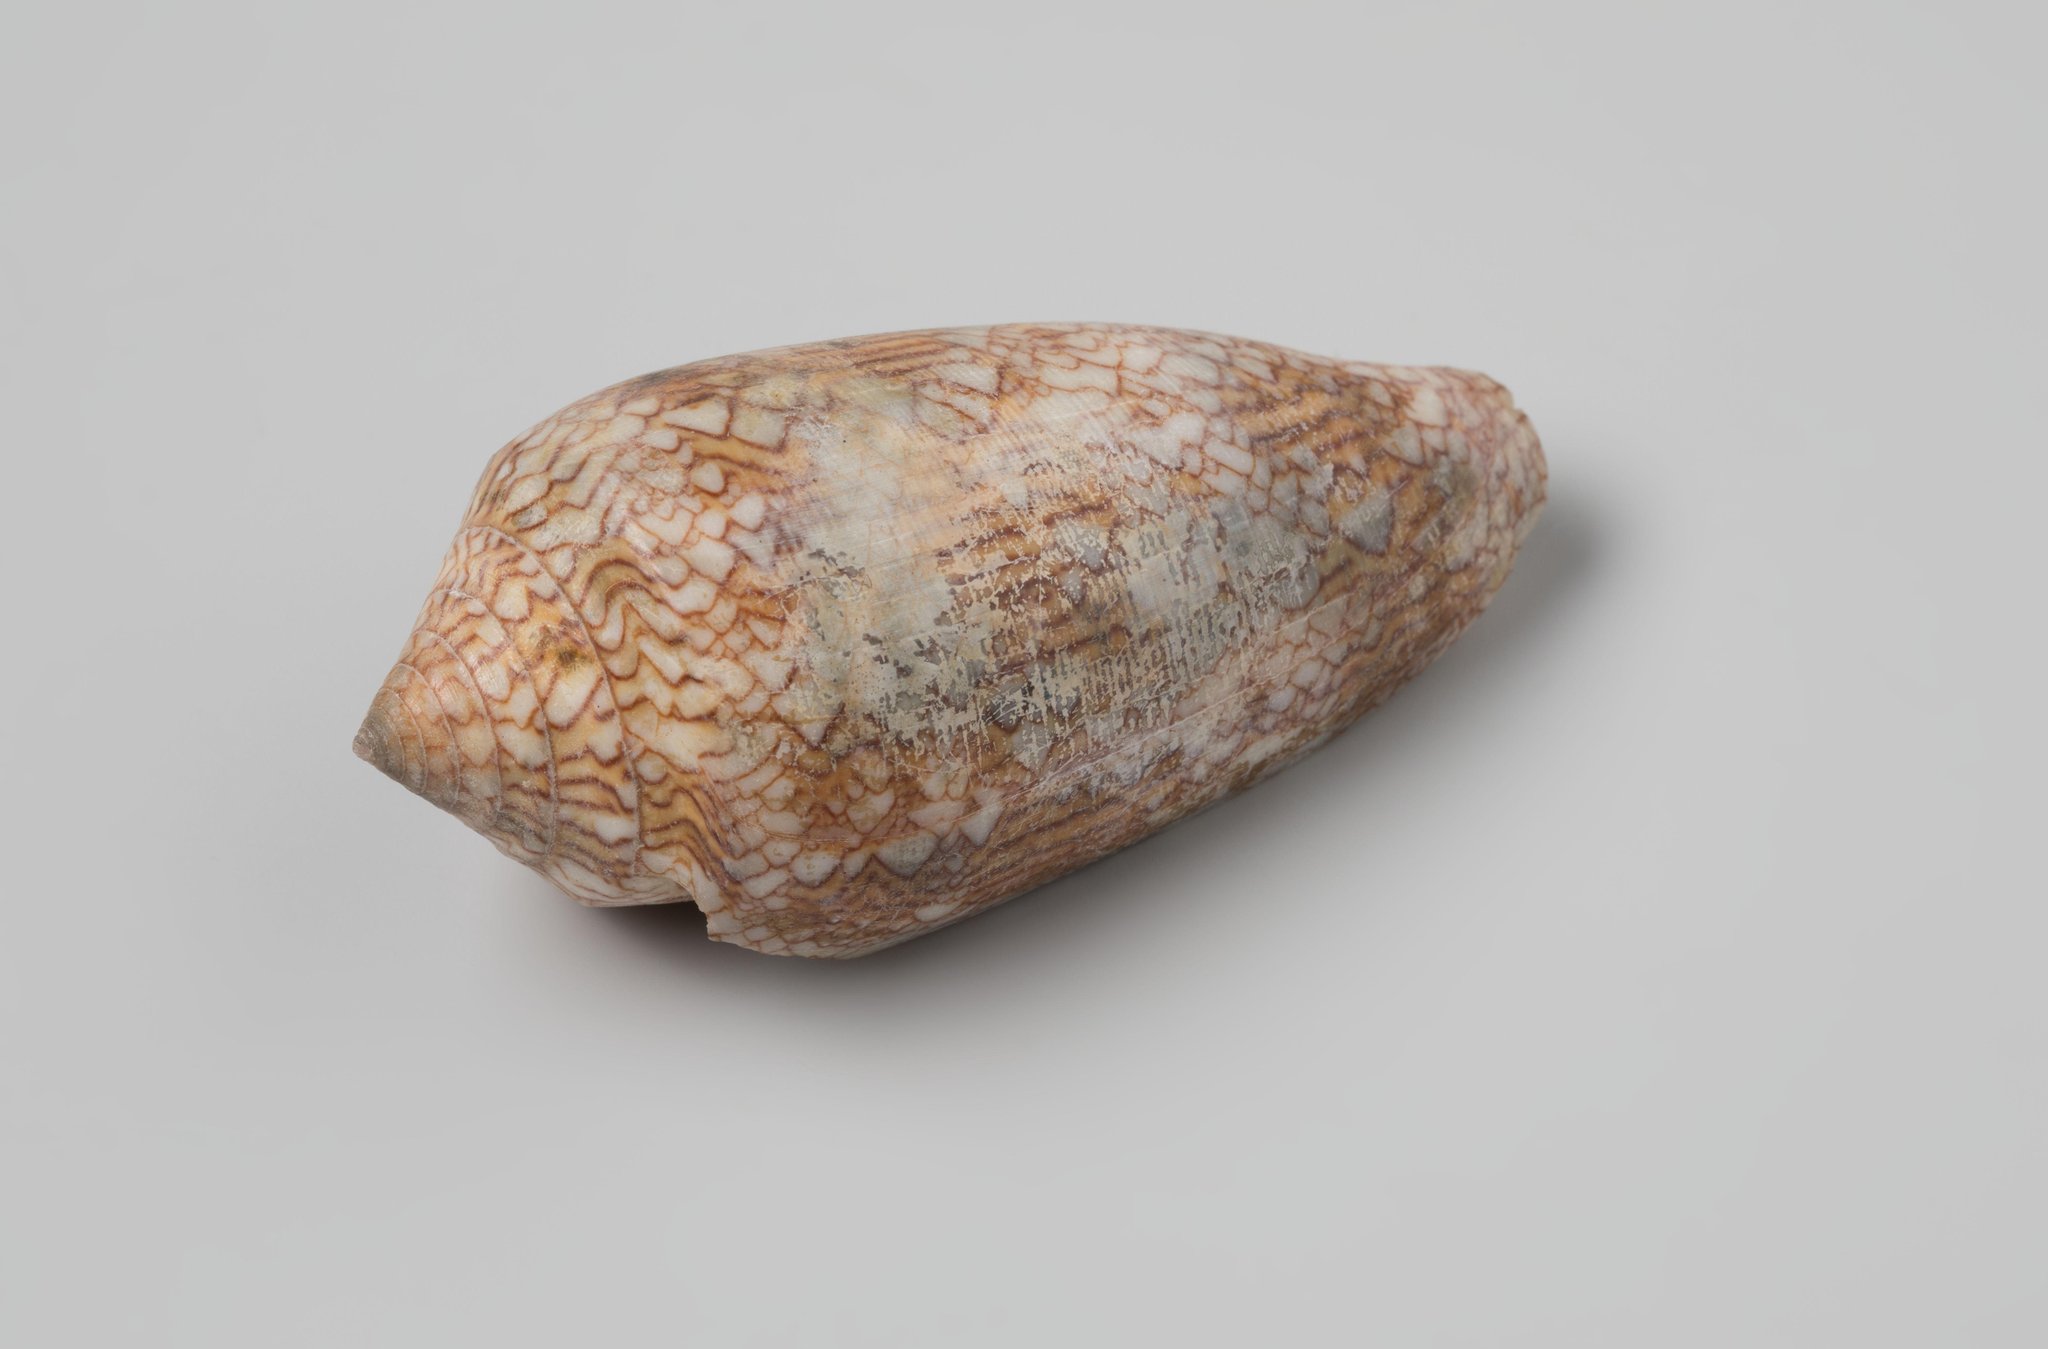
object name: conus textile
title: Conus textile shell from the wreck of the Dutch East India ship Witte Leeuw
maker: niet van toepassing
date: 1613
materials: shell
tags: verenigde oostindische compagnie, sint-helena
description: Schelp uit V.O.C.-schip de 'Witte Leeuw'.